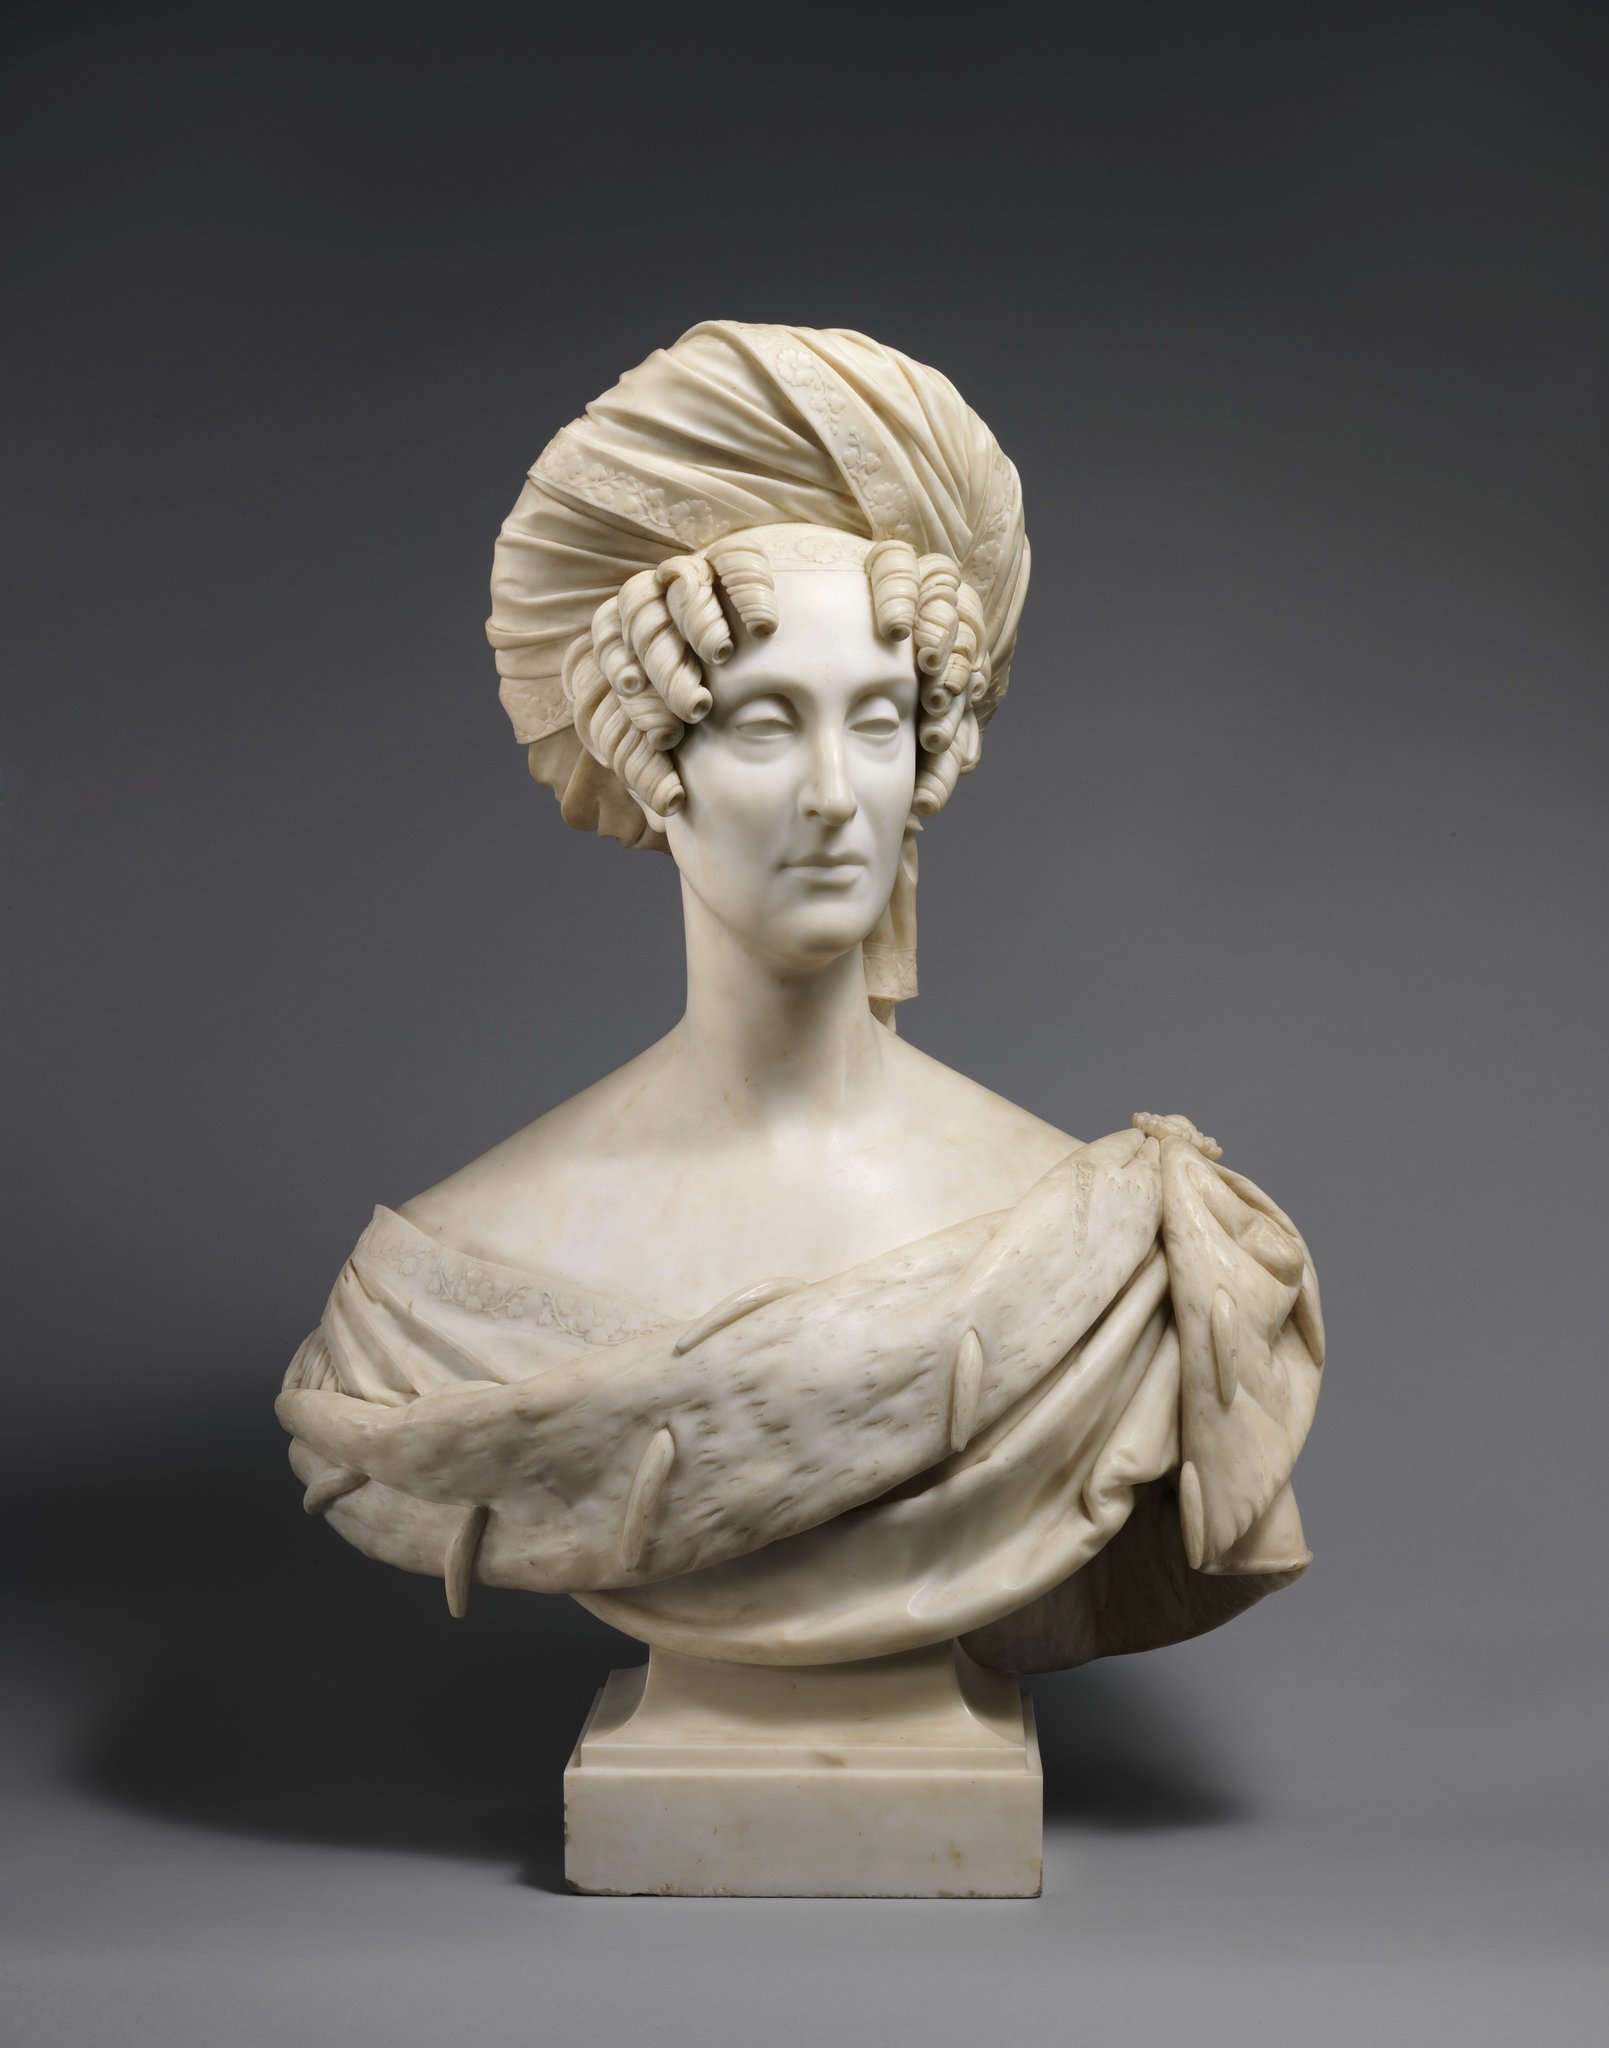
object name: bust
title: Marie-Amélie, Queen of the French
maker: baron françois joseph bosio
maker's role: artist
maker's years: 1768-1845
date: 1841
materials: marble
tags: queens,portraits